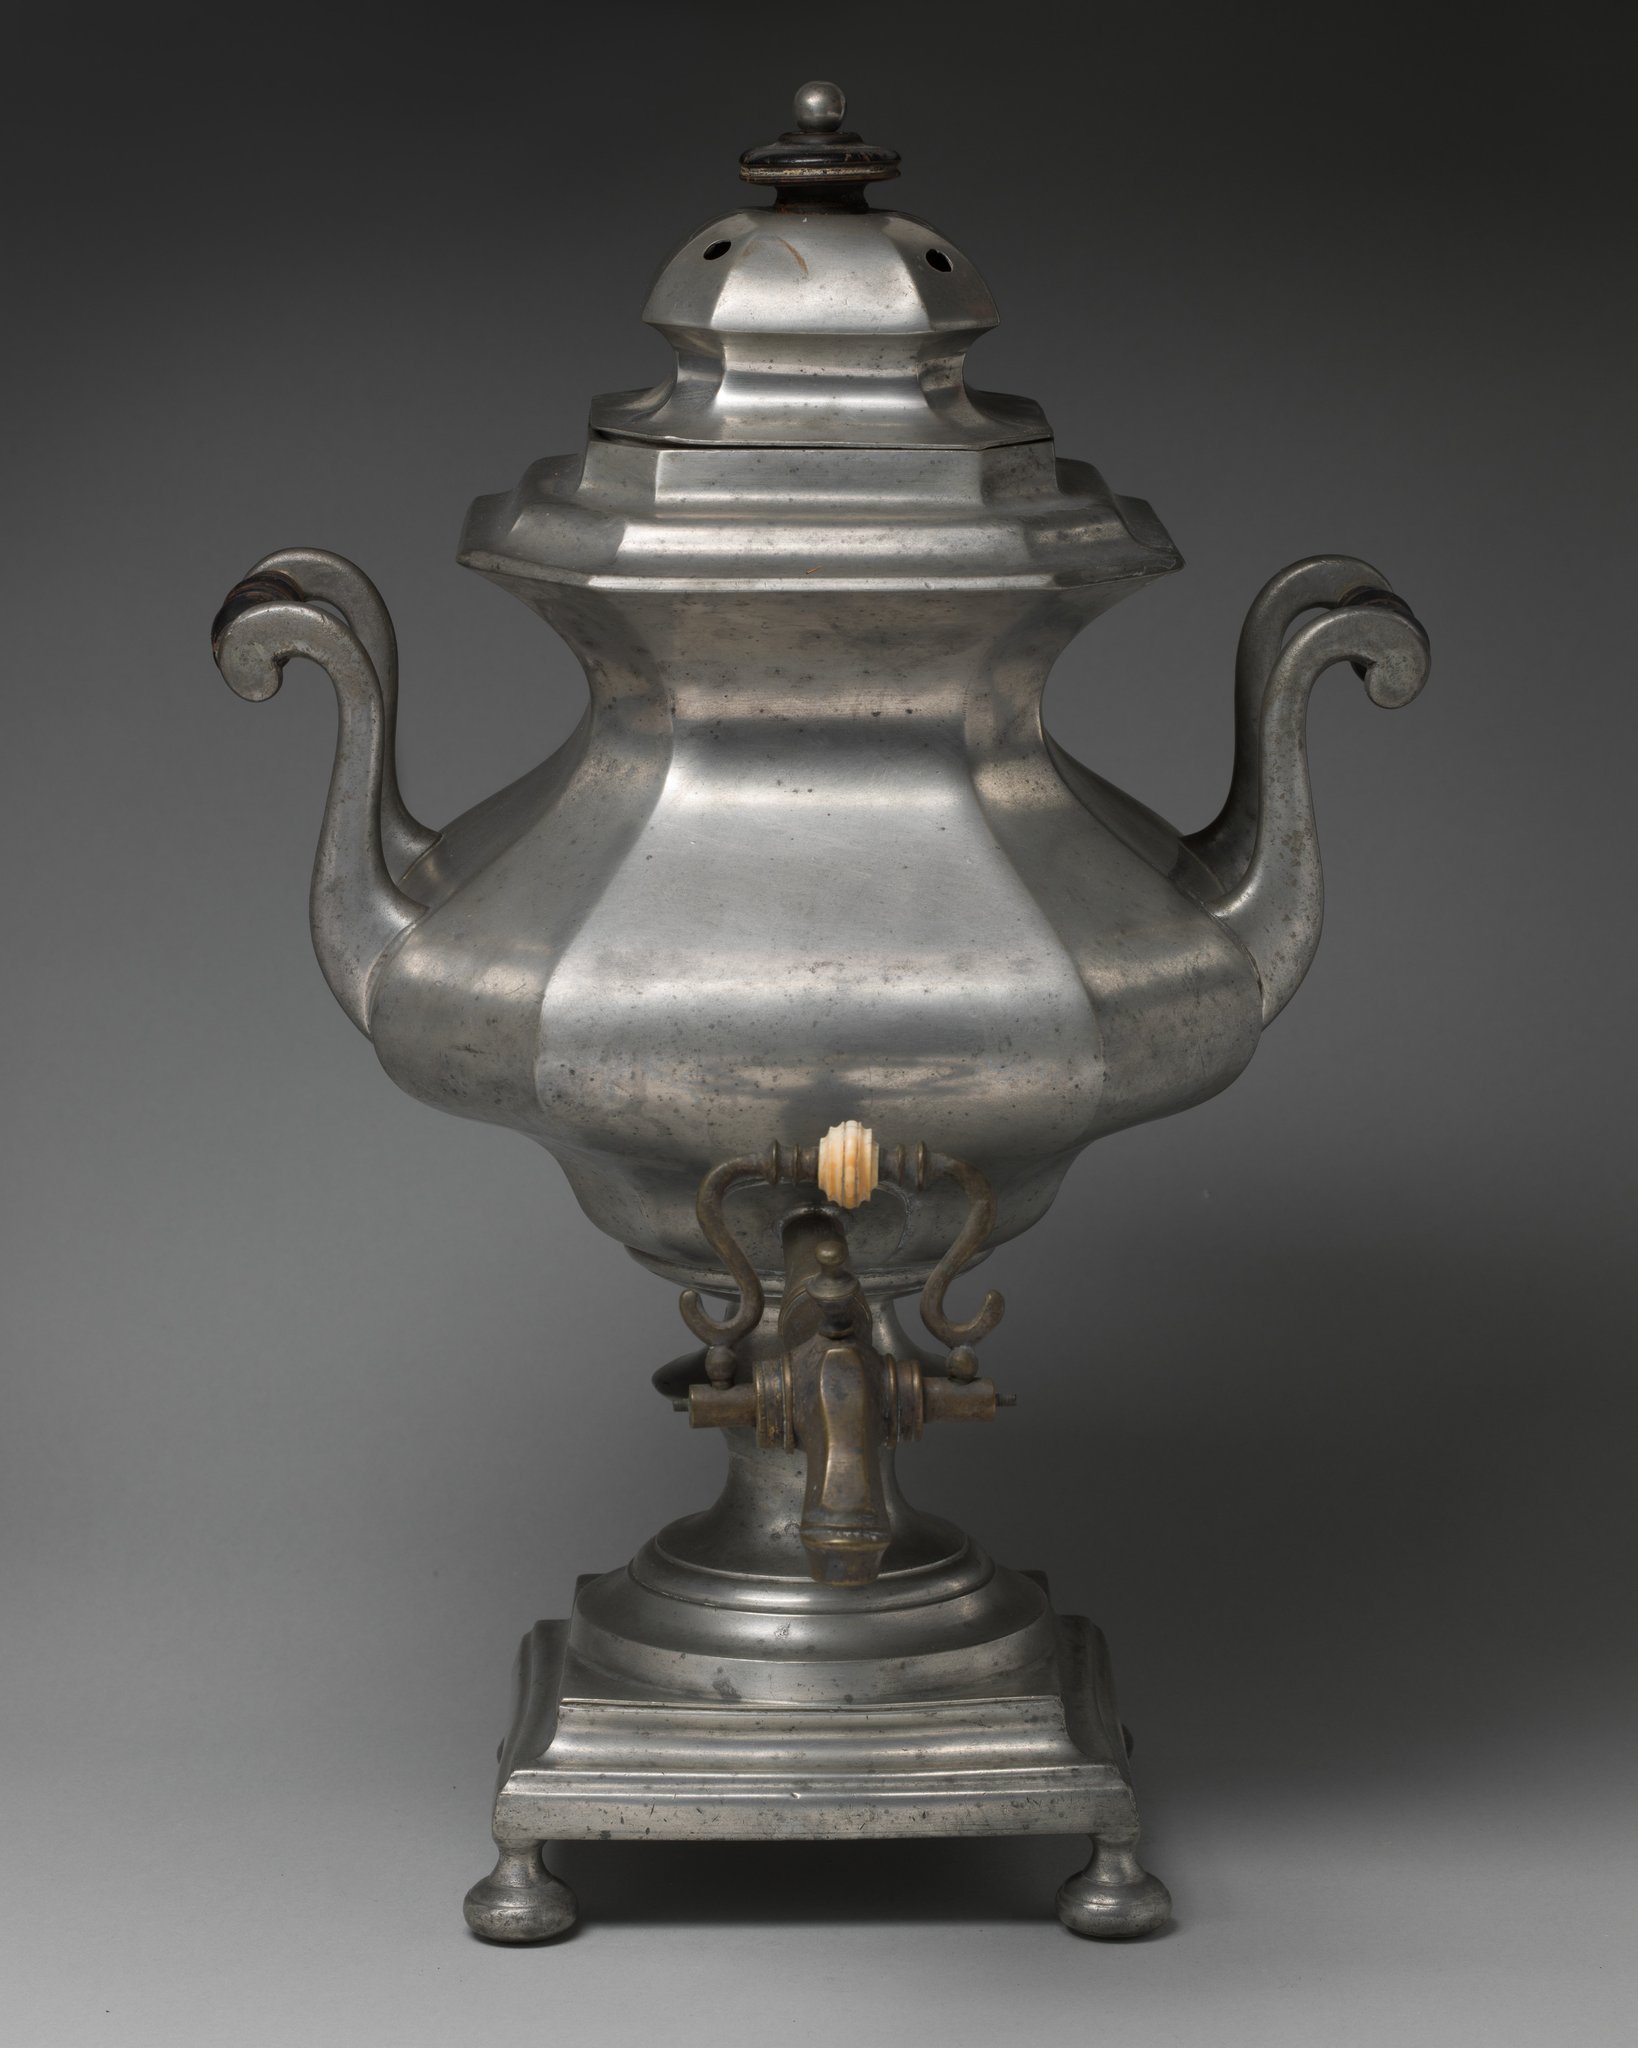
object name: tea urn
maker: james dixon & sons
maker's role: maker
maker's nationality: british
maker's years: 1806-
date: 1830-1834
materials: metal